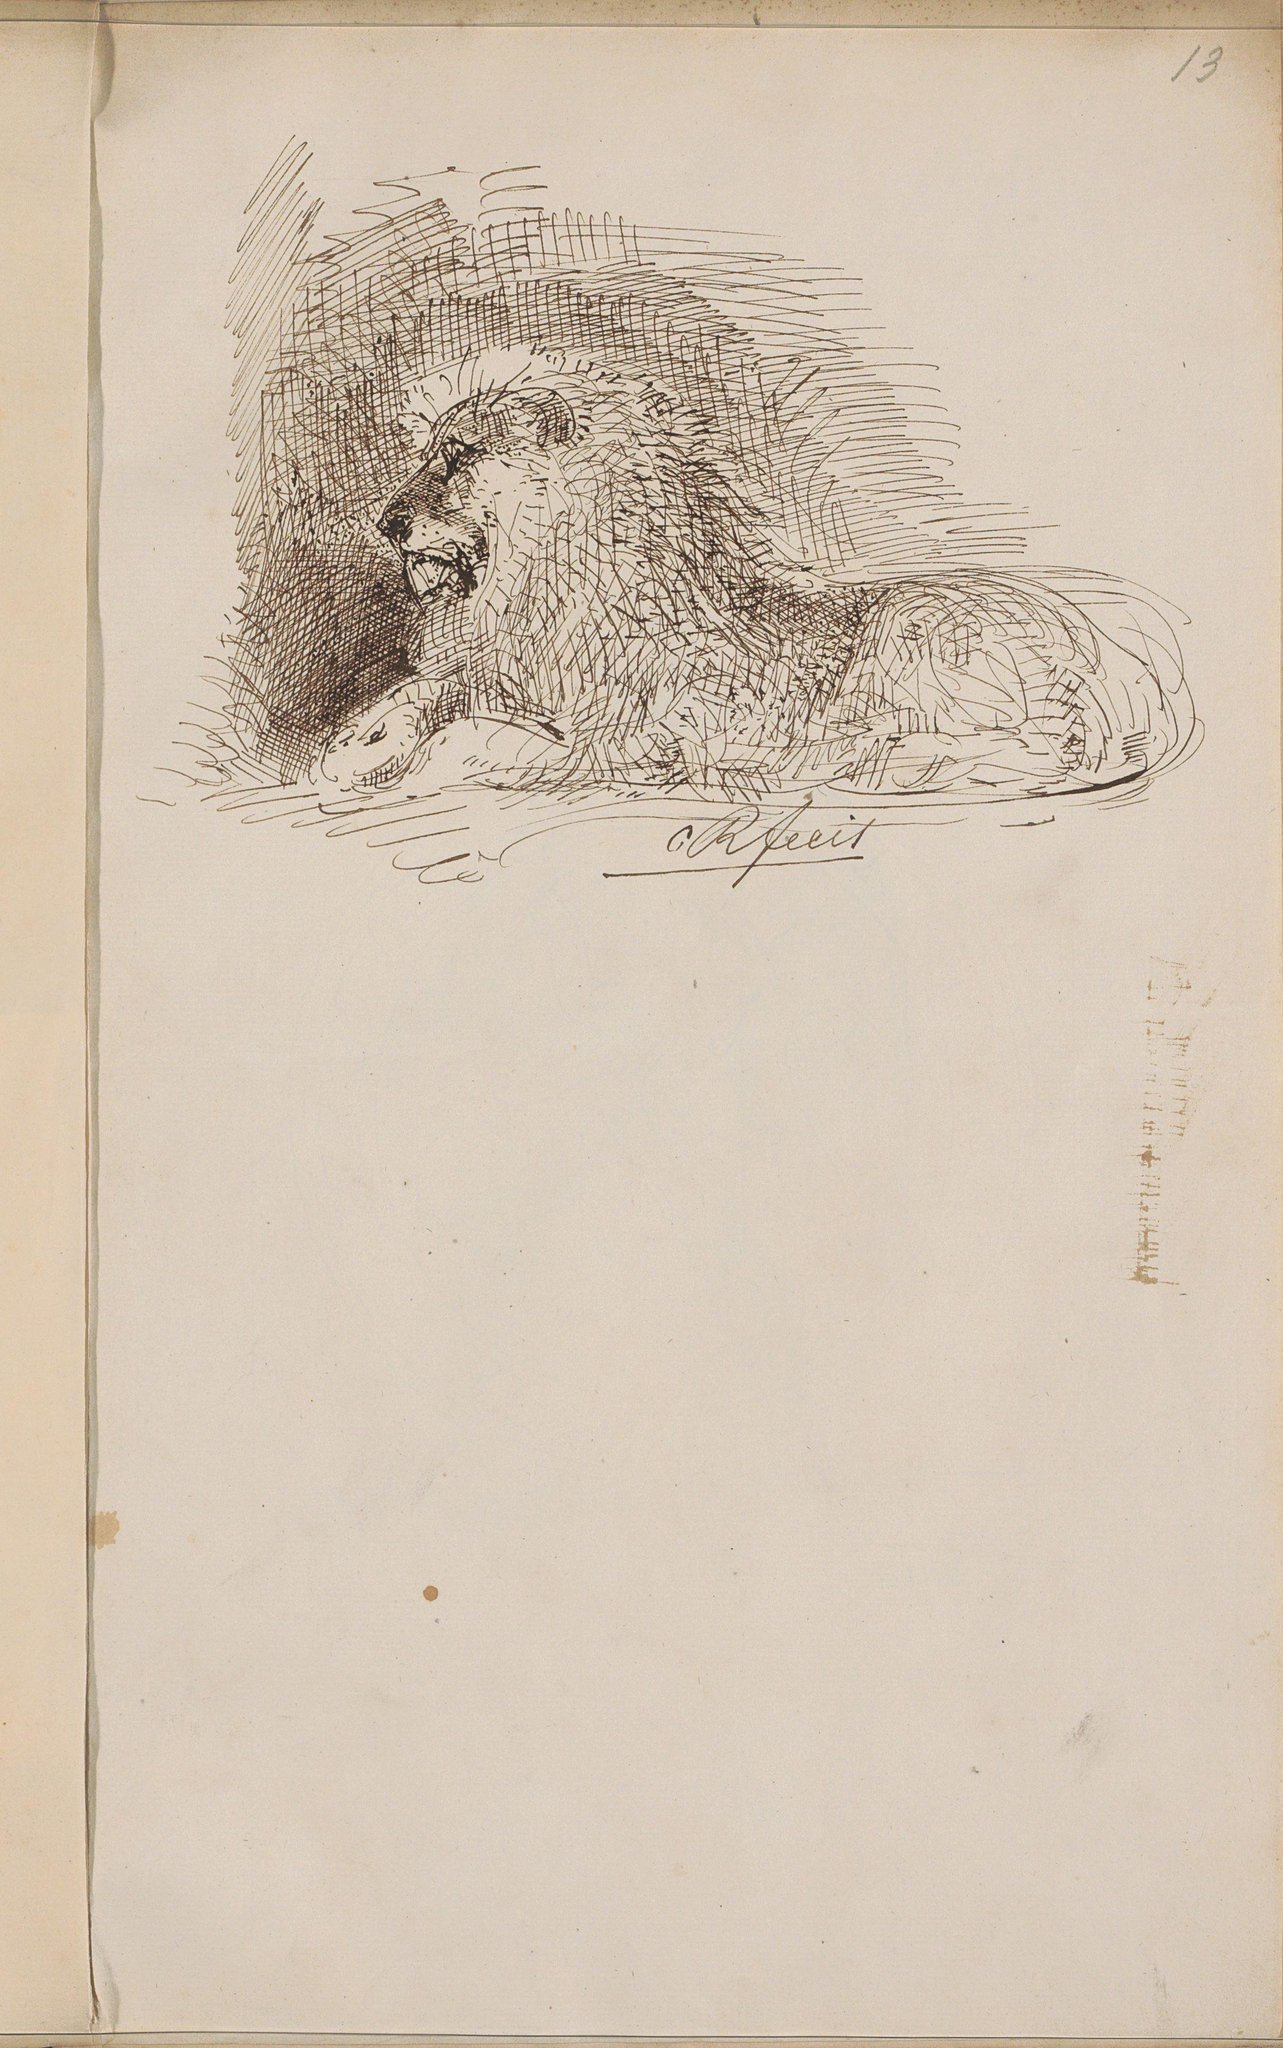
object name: album leaf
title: Liggende leeuw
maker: charles rochussen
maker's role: draughtsman, painter, print maker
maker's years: 1814-1894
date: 1843-1864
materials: ink, paper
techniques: pen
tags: beasts of prey, predatory animals: lion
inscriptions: signature: ‘c R fecit’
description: Blad 13 recto uit een verzamelalbum met 32 bladen.